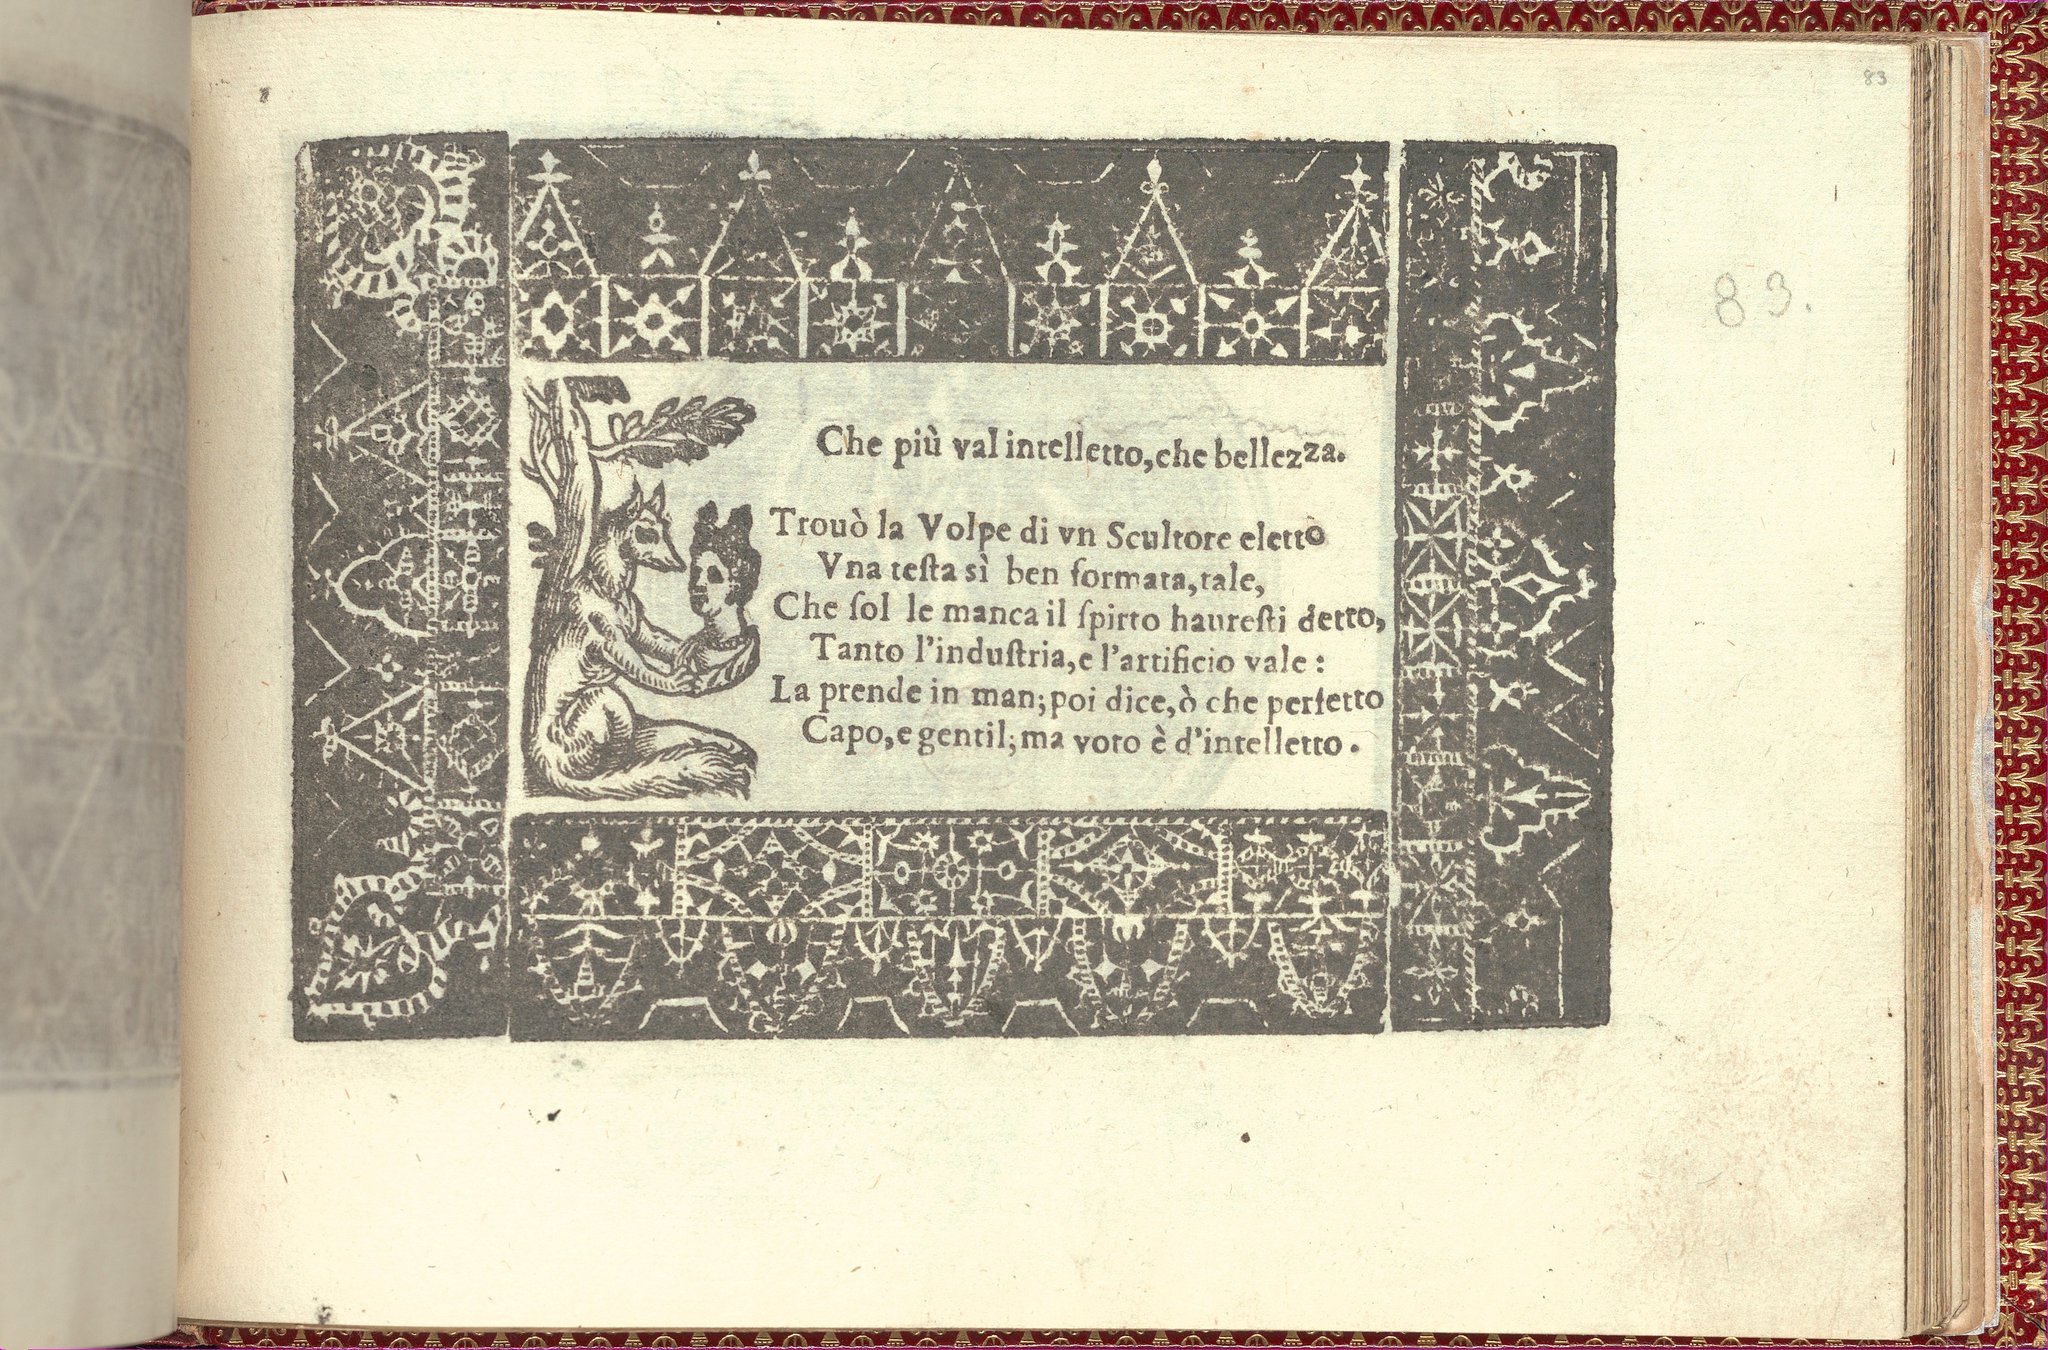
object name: book print ornament architecture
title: Corona delle Nobili et Virtuose Donne: Libro I-IV, page 83 (recto)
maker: cesare vecellio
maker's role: publisher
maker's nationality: italian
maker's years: 1521-1601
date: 1601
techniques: woodcut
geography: italy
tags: poetry,sculpture,women,foxes